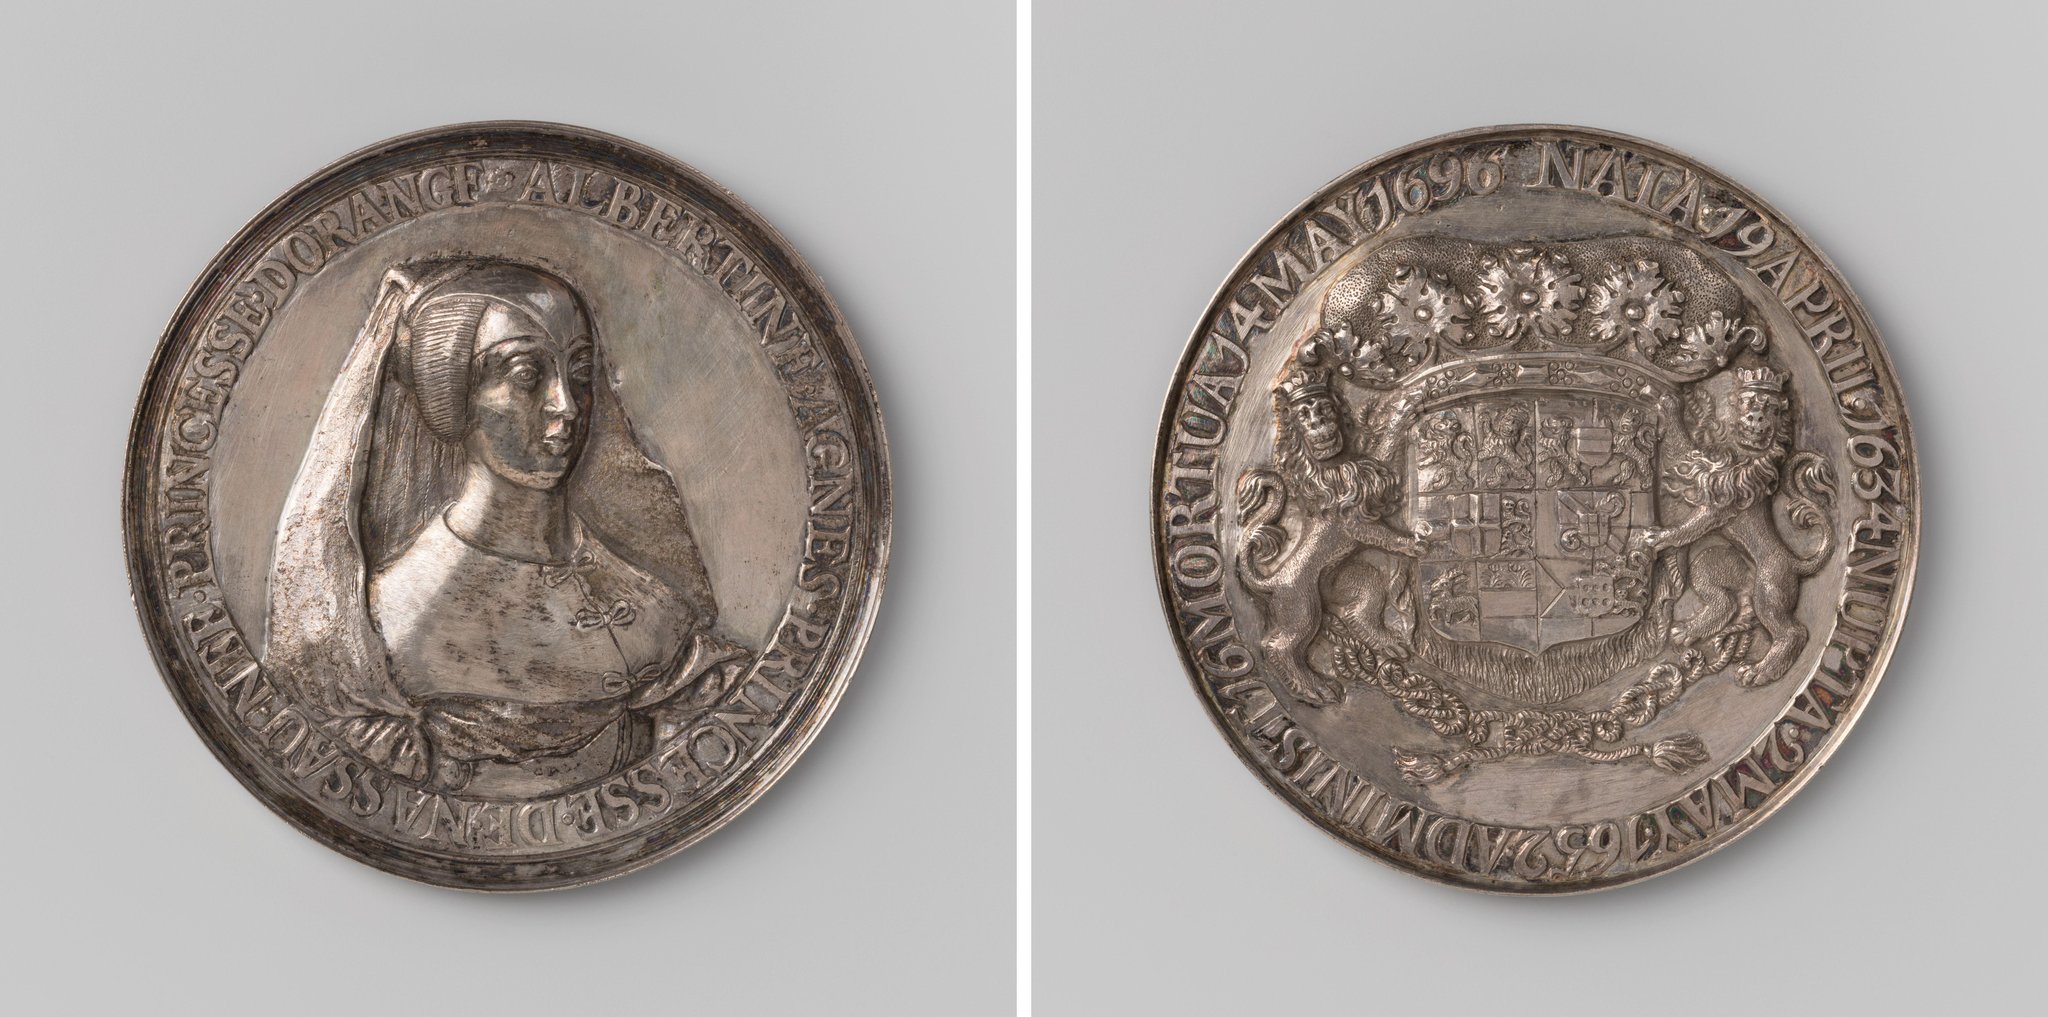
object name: history medal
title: Albertine Agnes, Princess of Orange-Nassau (1634-1696)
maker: Anonymous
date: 1696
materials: silver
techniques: casting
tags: the hague, albertine agnes (prinses van oranje)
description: Most coins have a side with a portrait, usually of a ruler. In addition, portrait medals have also always been made, primarily to honour, commemorate, or glorify an important event or person. They were often intended for a general public. Some were destined to be family heirlooms. In any case, the medallists tried to make the likenesses as realistic as possible. That is why they are considered a separate genre.